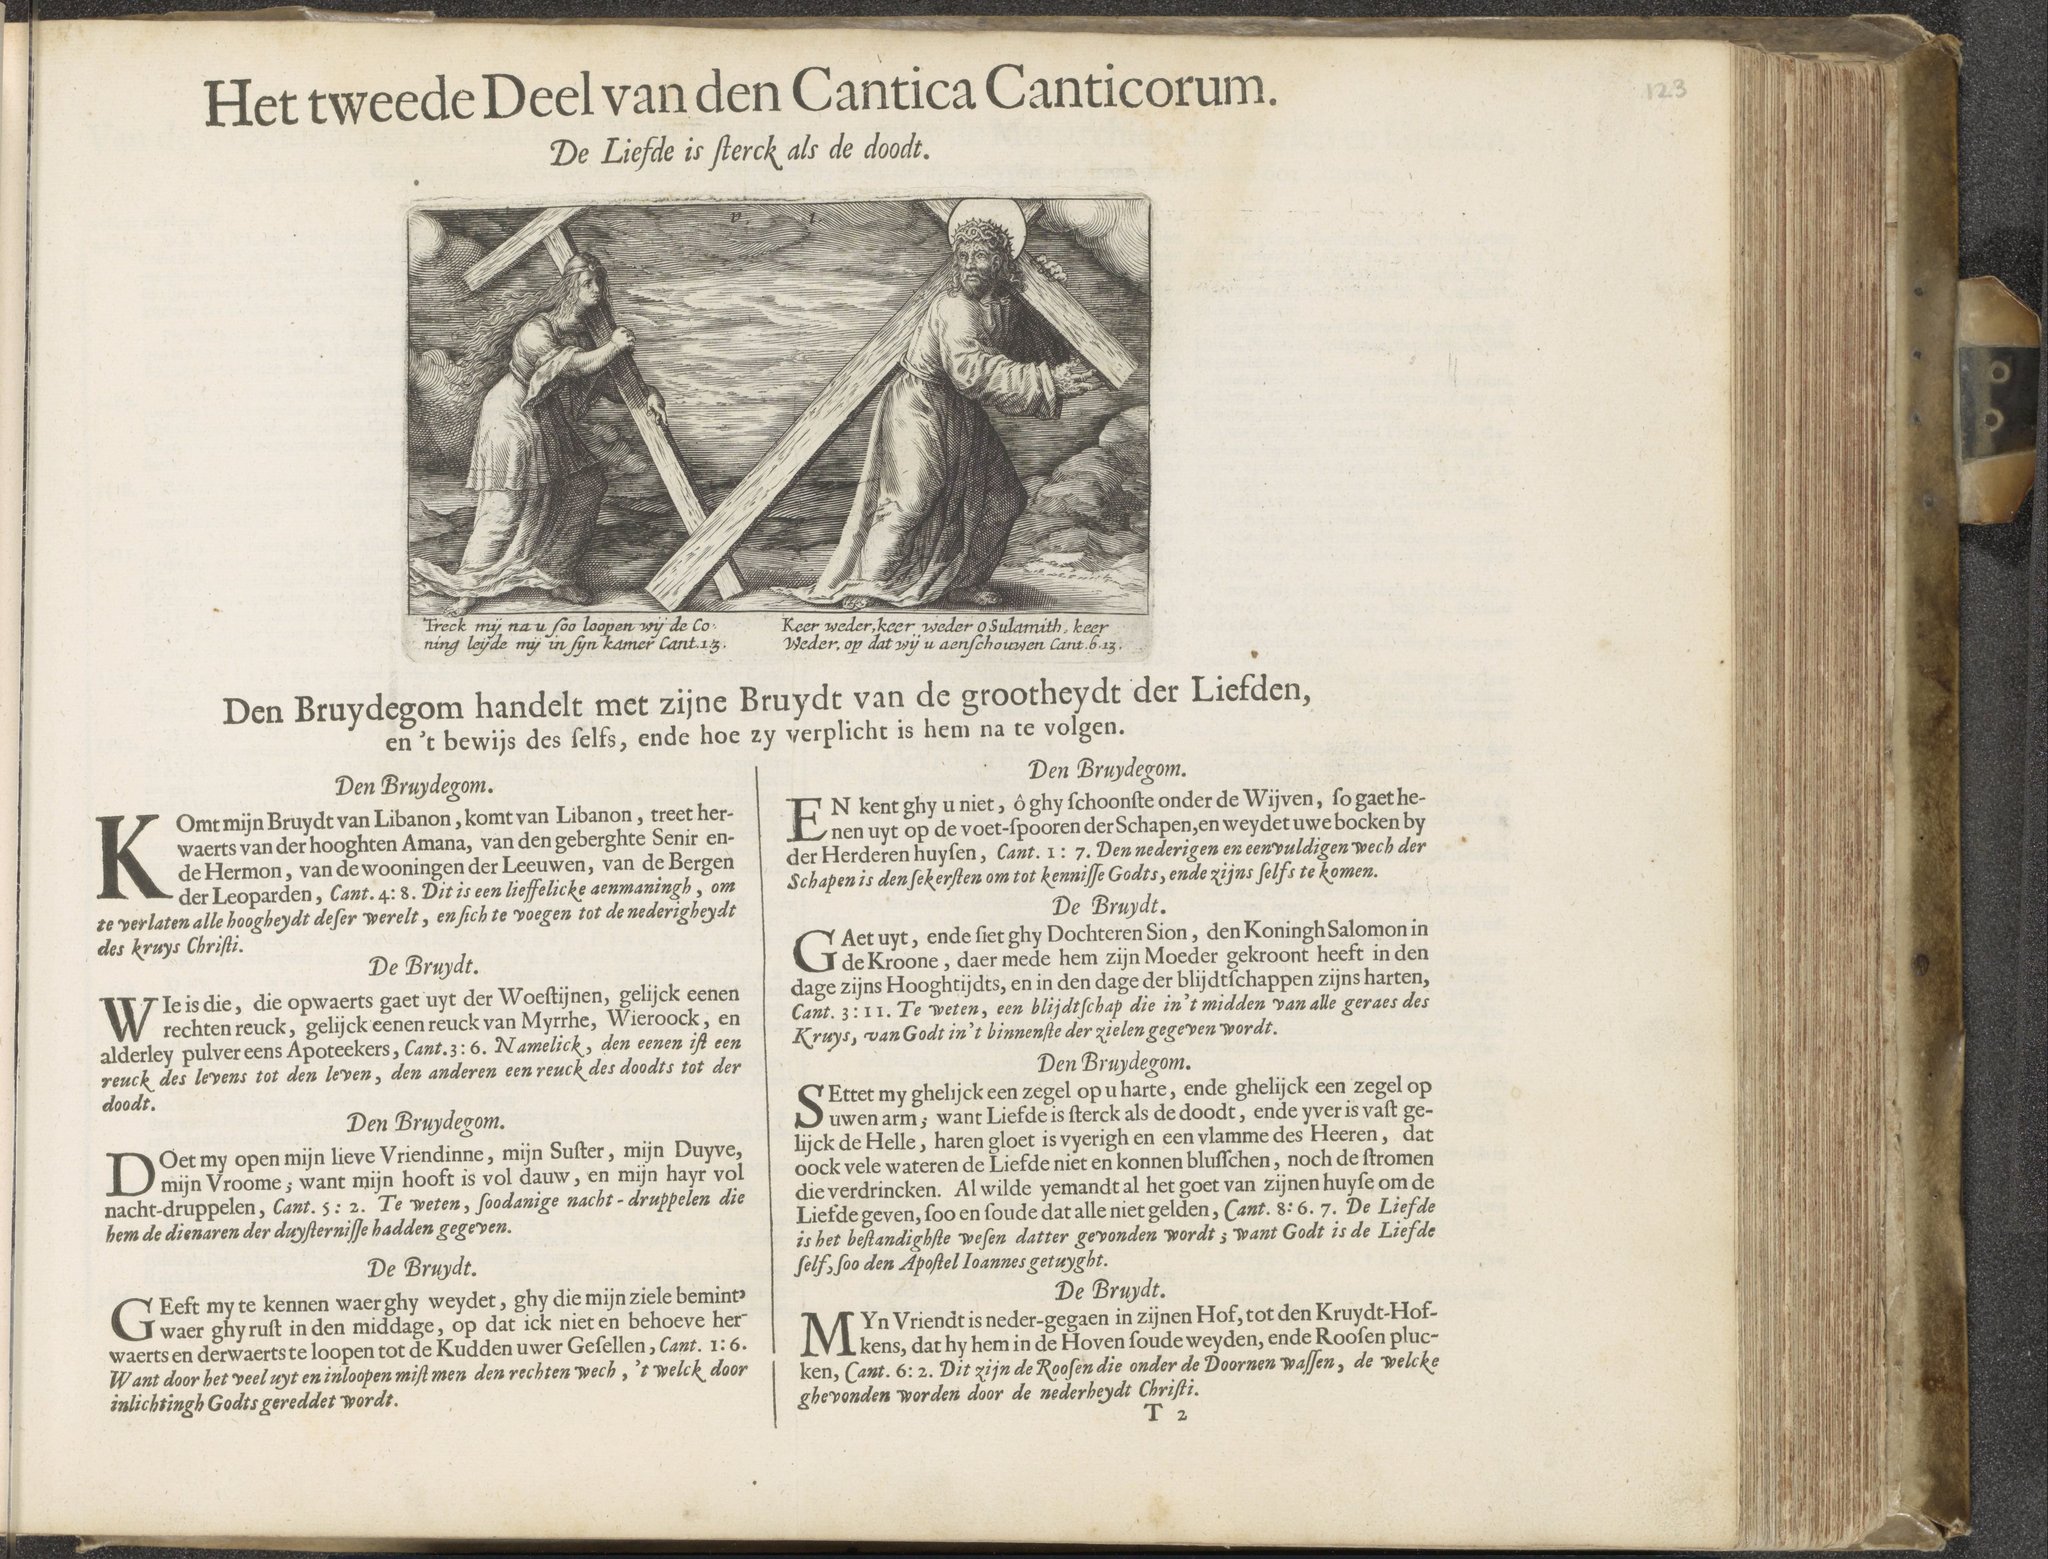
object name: album leaf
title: Den Grooten Emblemata Sacra, bestaande in meer dan vier hondert bybelsche figuren, zoo des Ouden als des Nieuwen Testaments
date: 1653-1654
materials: paper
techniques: engraving, letterpress printing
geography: amsterdam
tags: 'ecclesia' as bride of christ (the lamb), 'ecclesia sponsa dei', 'sponsus-sponsa', christ, shulammite, the beloved woman ~ song of solomon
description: De bruid uit het Hooglied (de Sulamith) volgt Christus als kruisdrager. In de ondermarge vier regels Nederlandse tekst en verwijzingen naar Hooglied 1:3 en 6:13. Daarboven het motto: de liefde is sterck als de doodt. De begeleidende dialoog met het opschrift: den bruydegom handelt met zijne bruydt van de grootheyt der liefden en 't bewijs des selfs, ende hoe zy verplicht is hem na te volgen. Het blad maakt deel uit van een album.